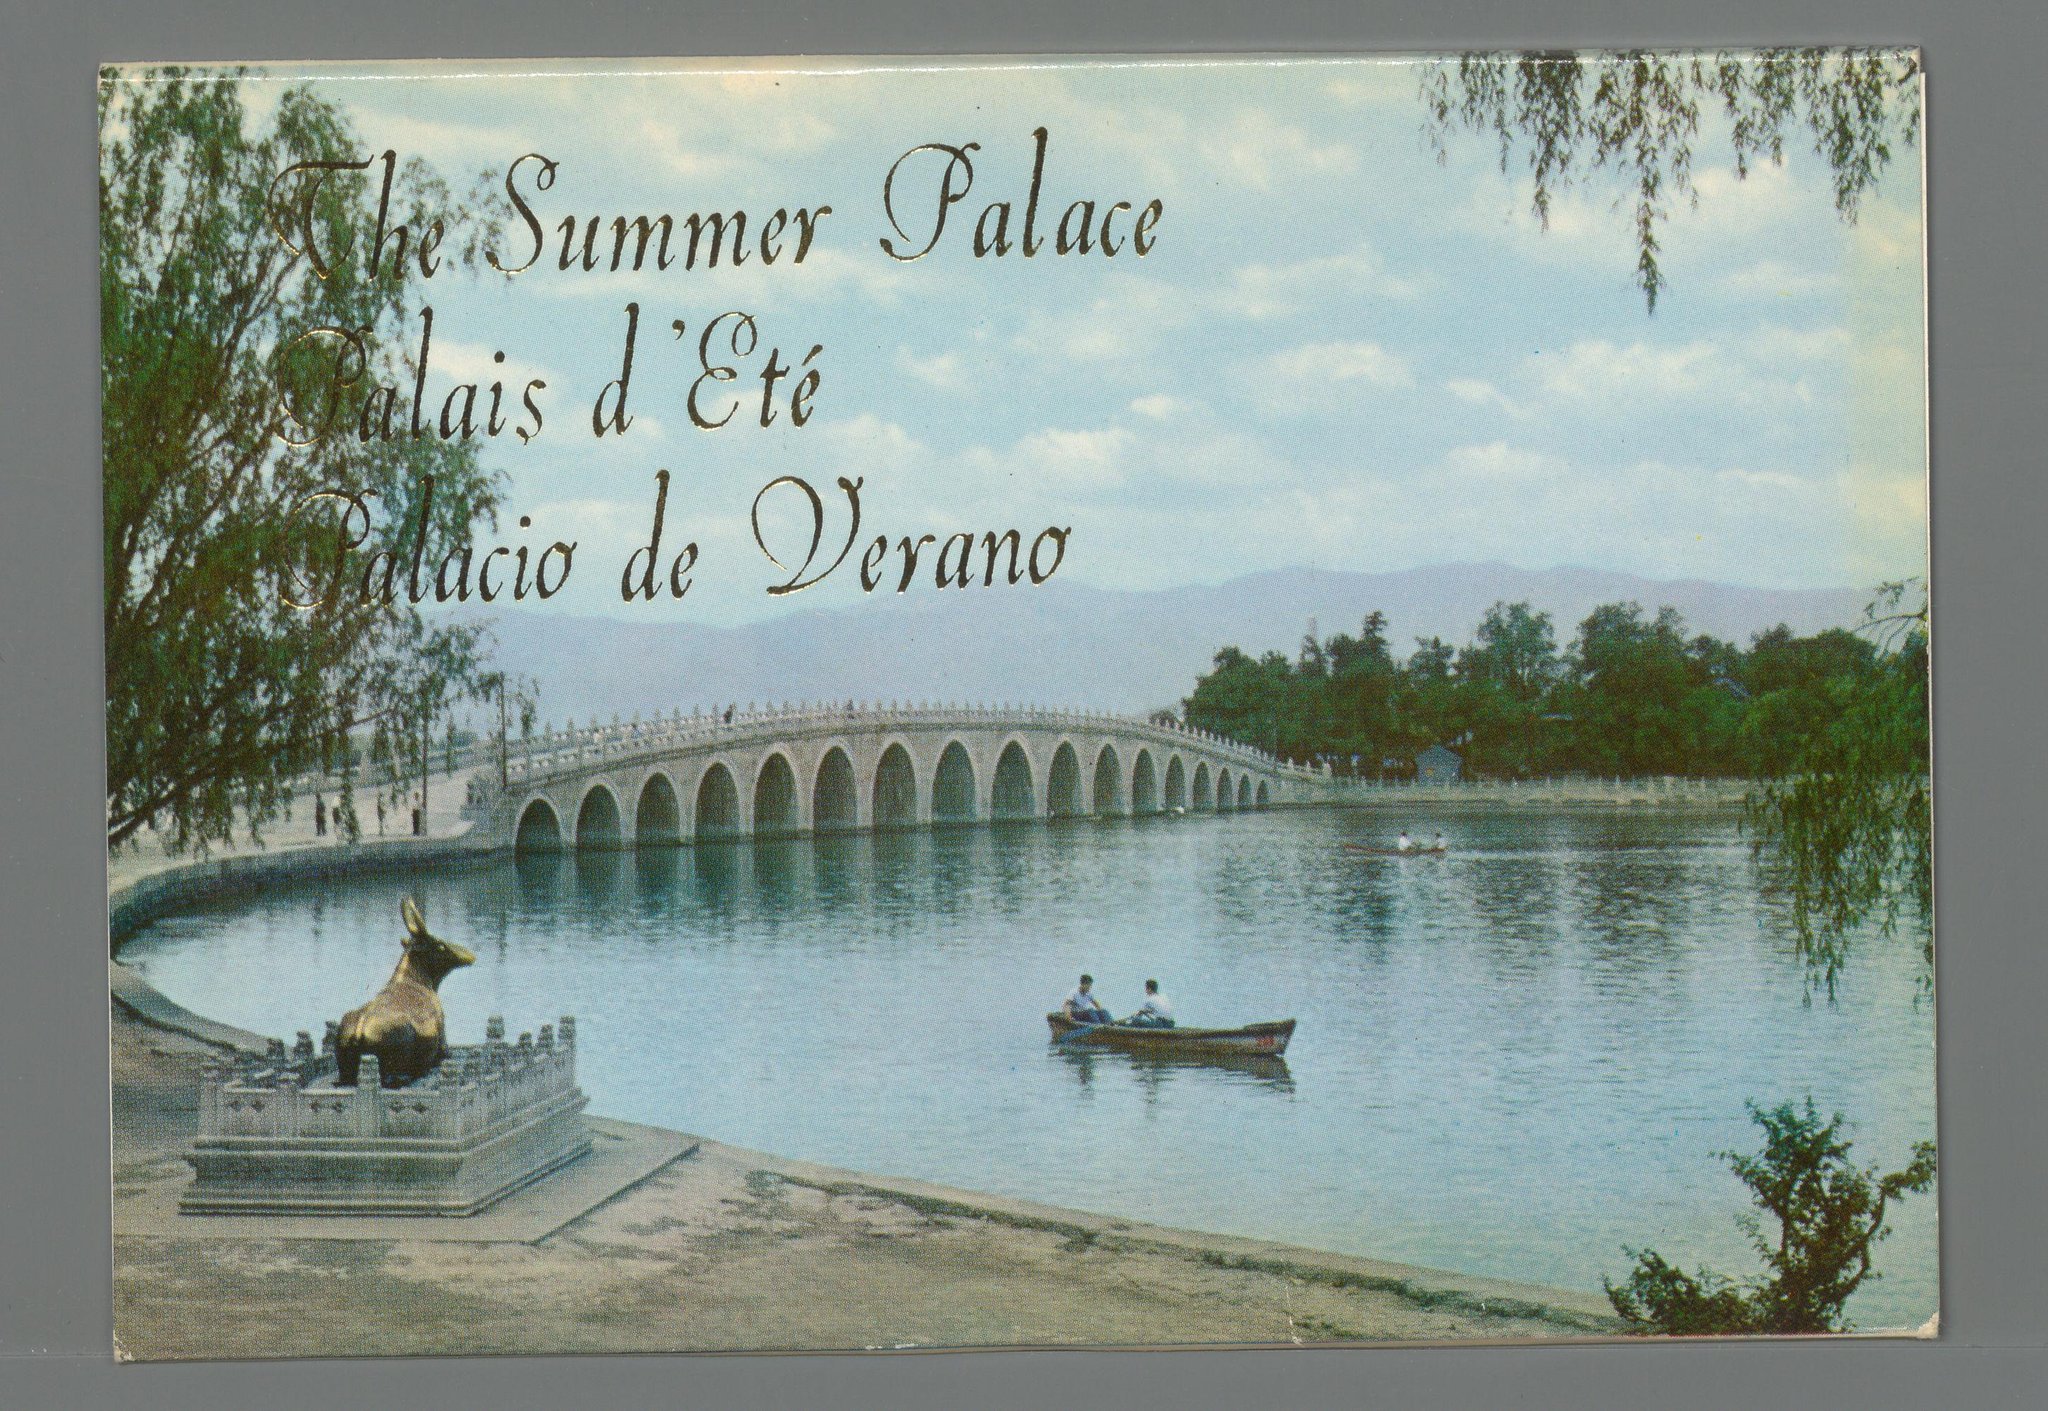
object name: photomechanical print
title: Omslag voor negen prentbriefkaarten met gezichten van het Zomerpaleis in Peking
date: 1974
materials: cardboard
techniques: offset printed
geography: beijing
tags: palace, lake, bridge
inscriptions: date